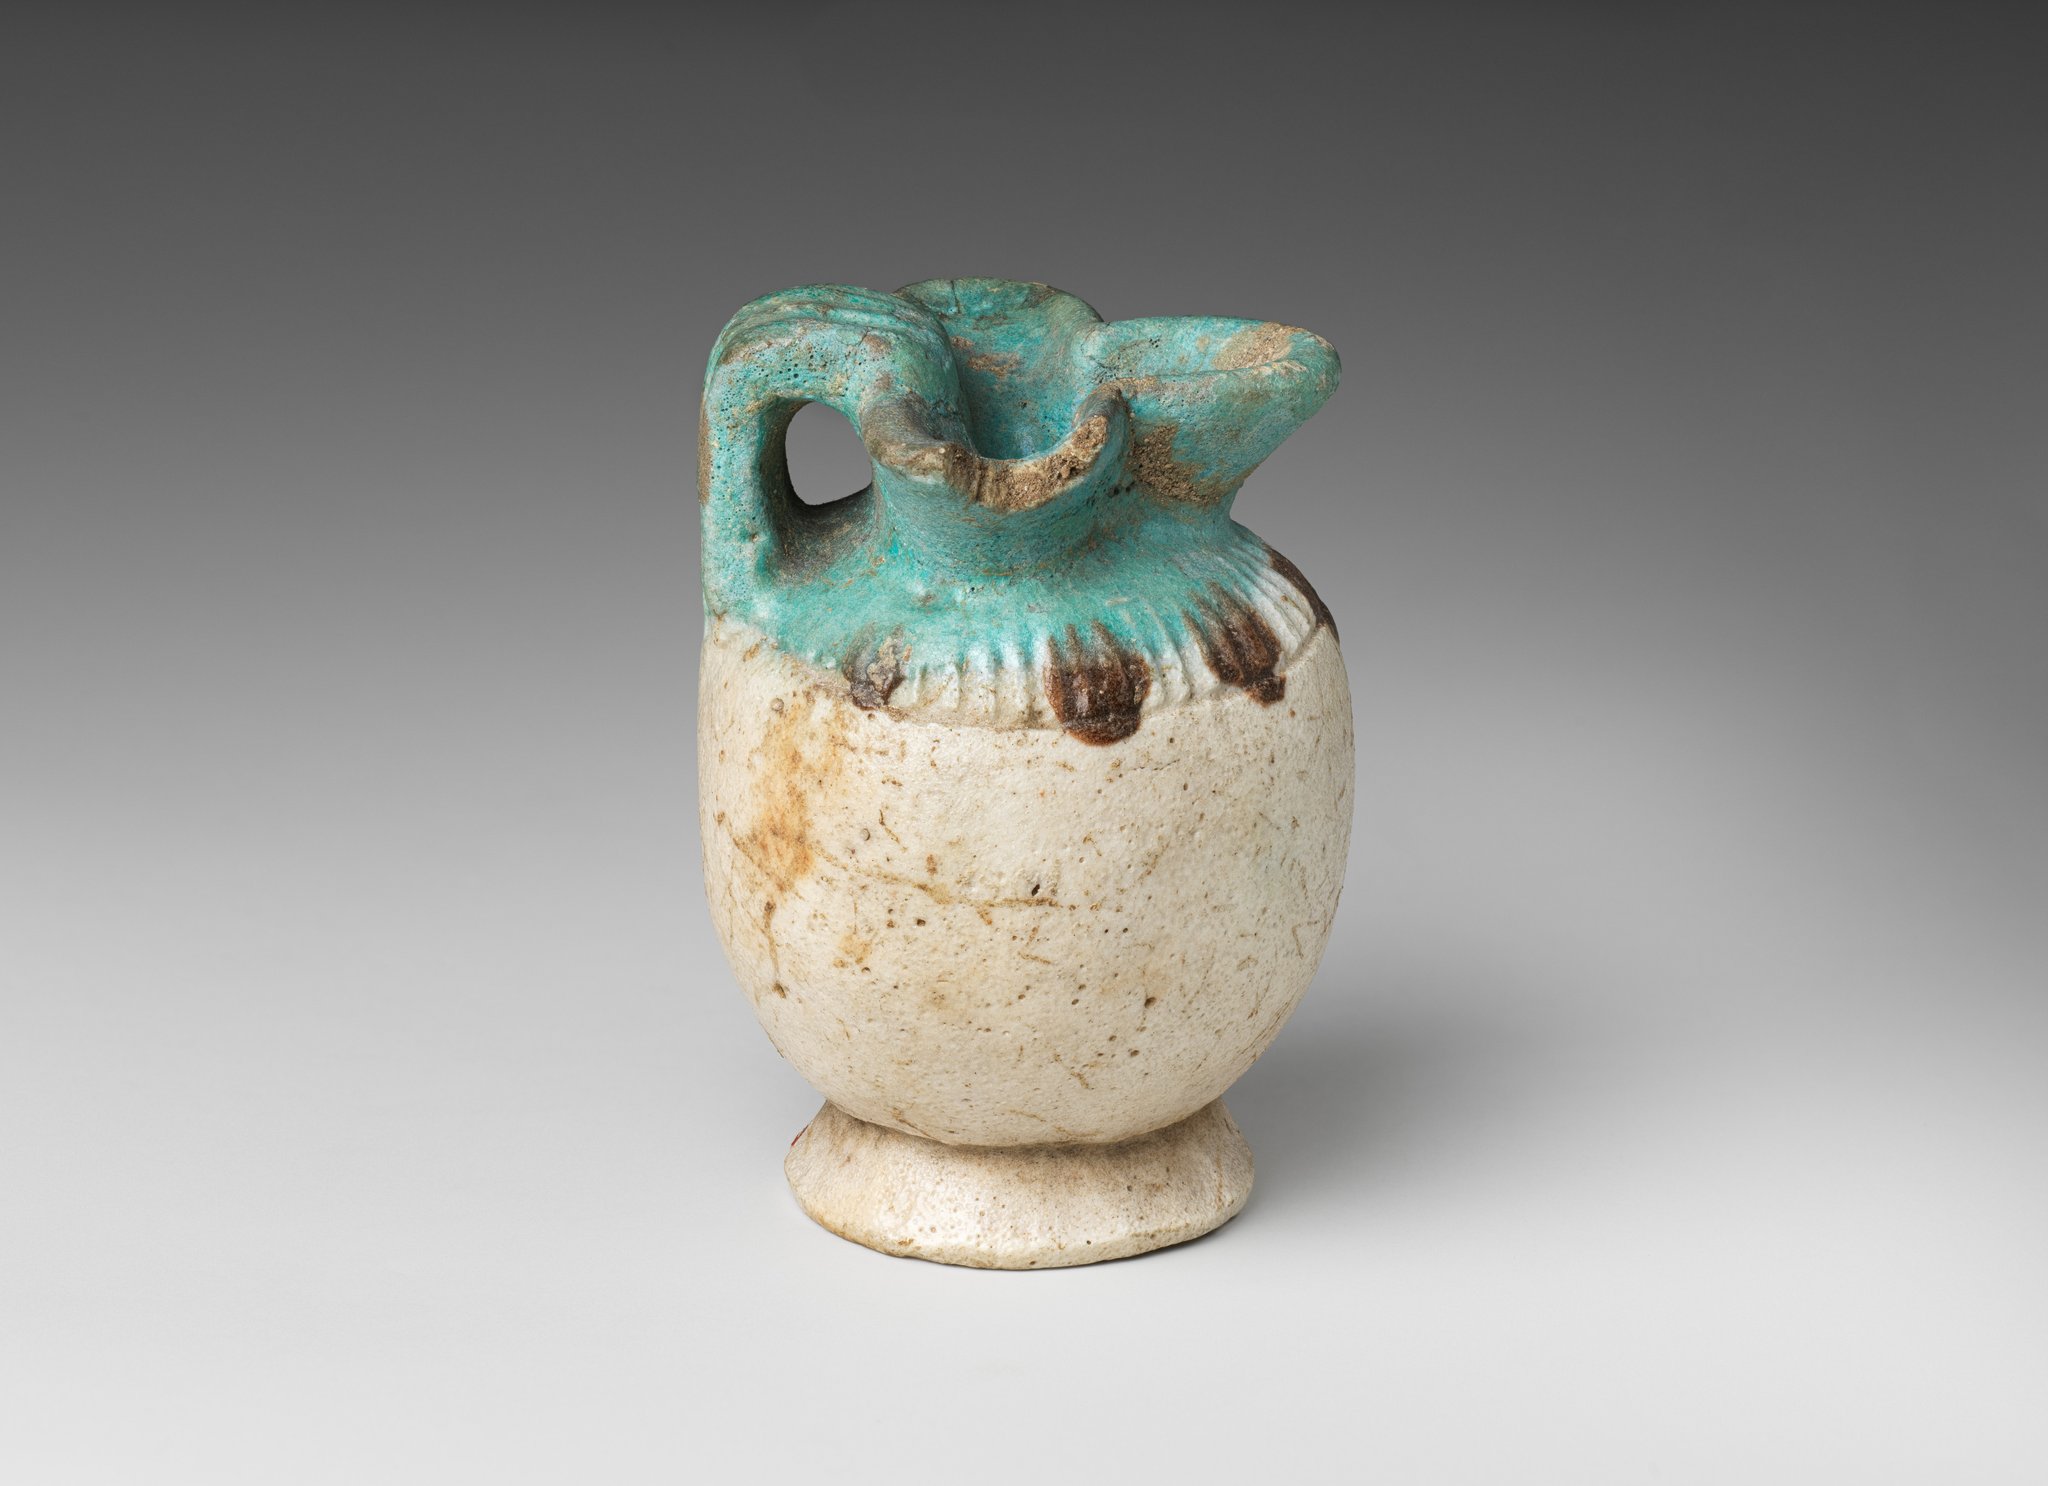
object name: aryballos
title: Aryballos (perfume vase) with trefoil opening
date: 600-501 BCE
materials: faience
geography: egypt